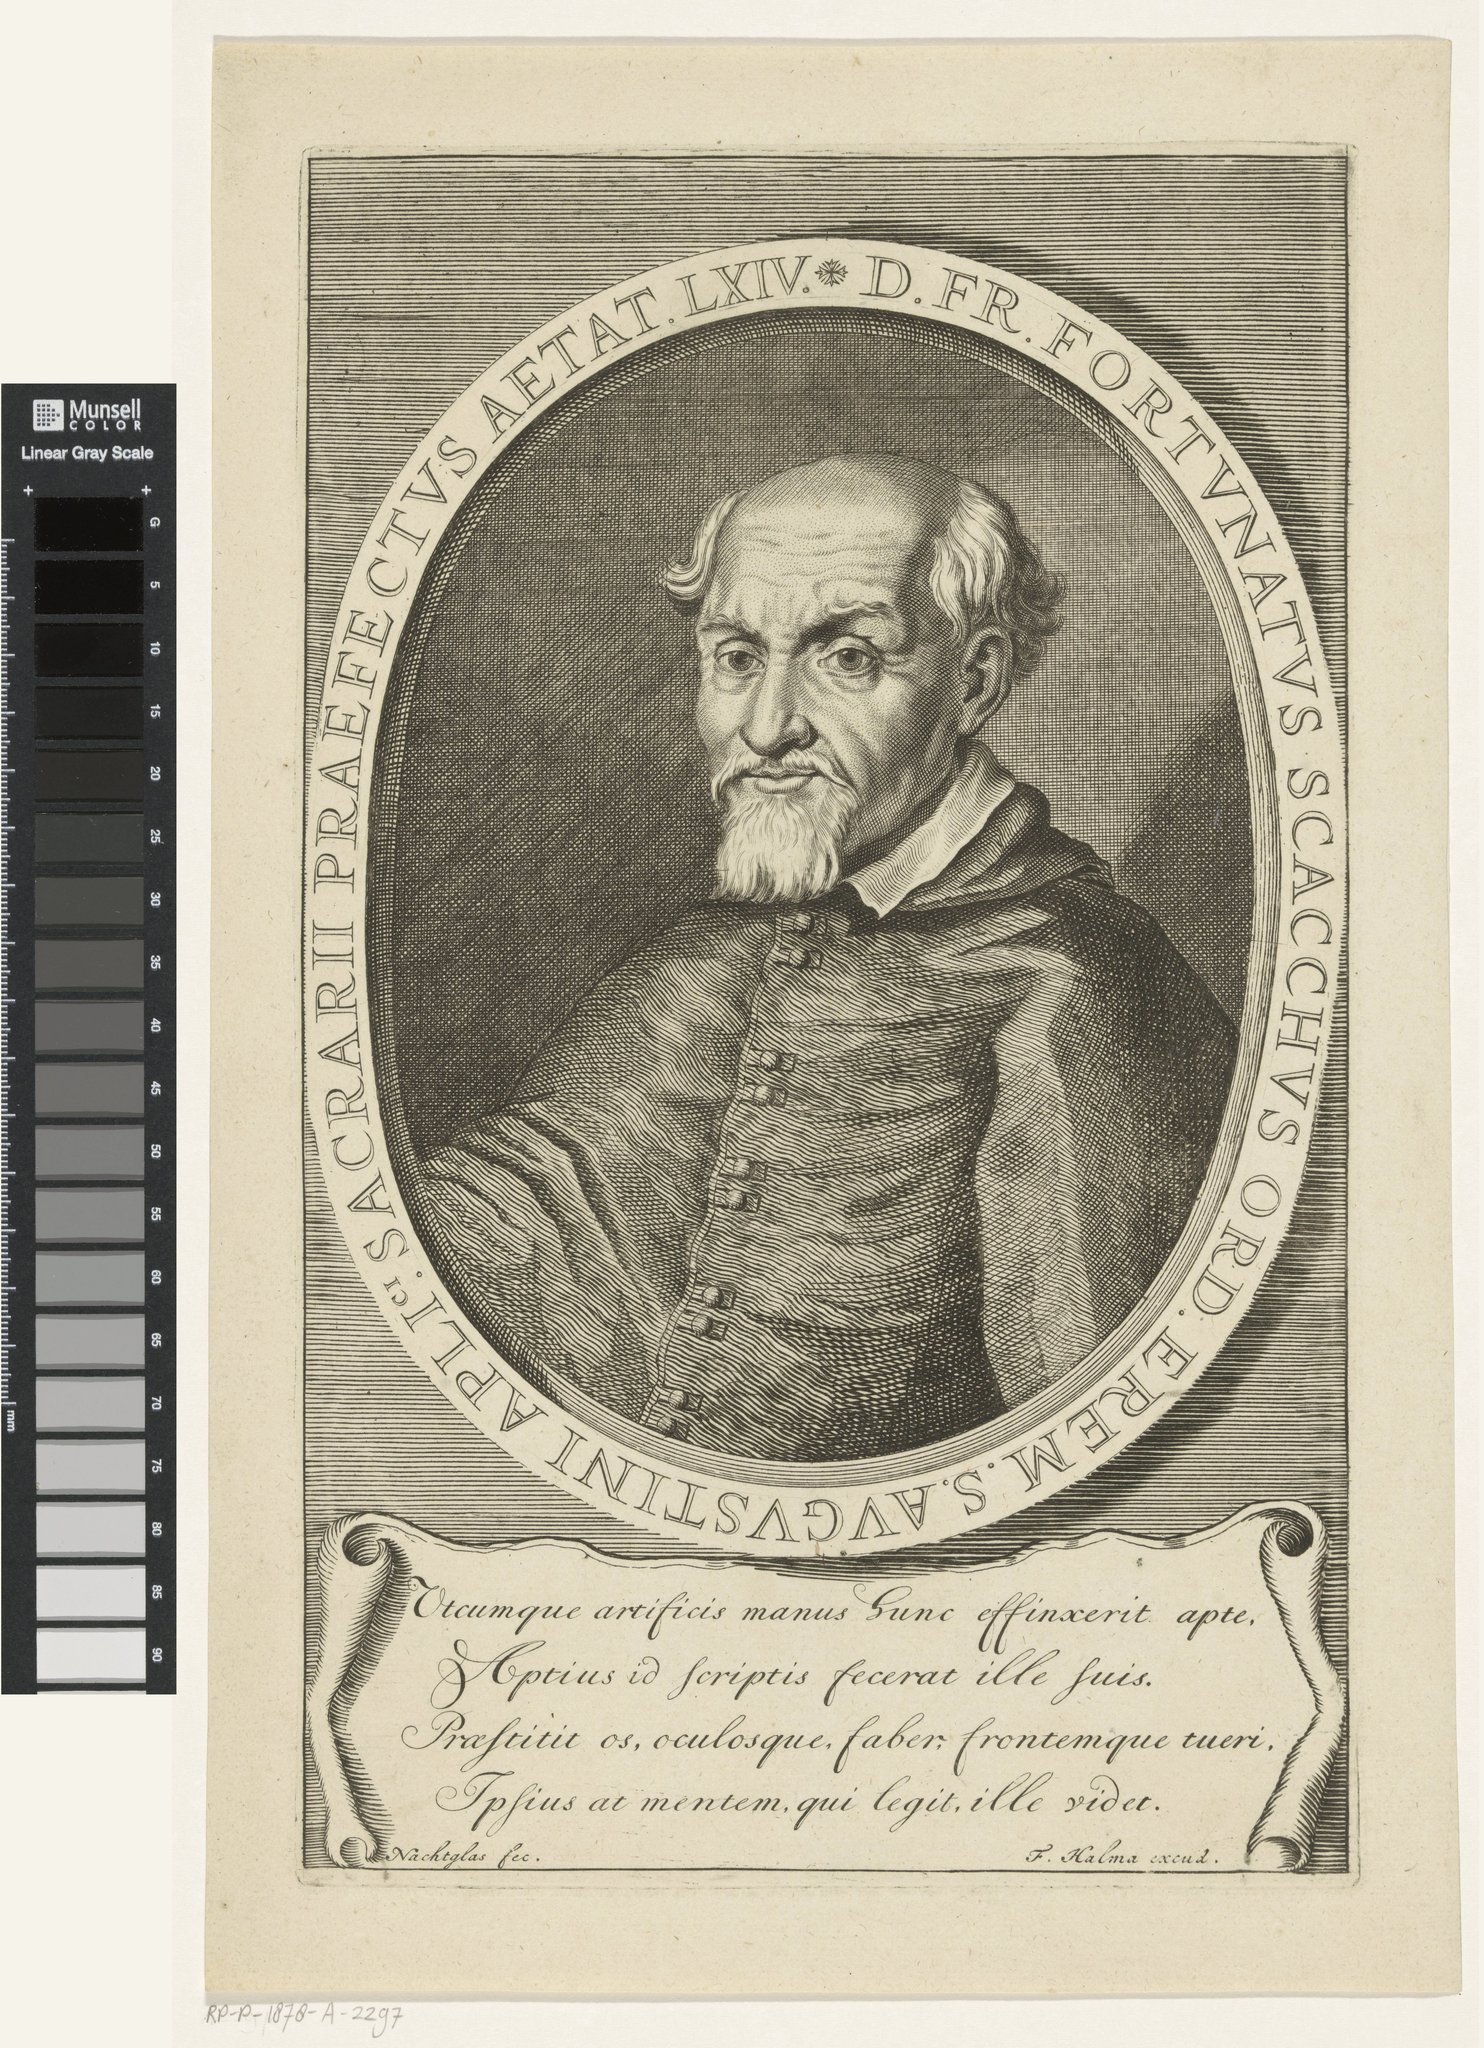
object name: print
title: Portret van Fortunato Scacchi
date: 1690-1710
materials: paper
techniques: engraving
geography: utrecht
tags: schrijver, fortunato scacchi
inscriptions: collector's mark: Lugt 2228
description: Buste van Fortunato Scacchi naar links in ovaal met randschrift in het Latijn. Onder in de marge een vierregelige tekst in het Latijn.